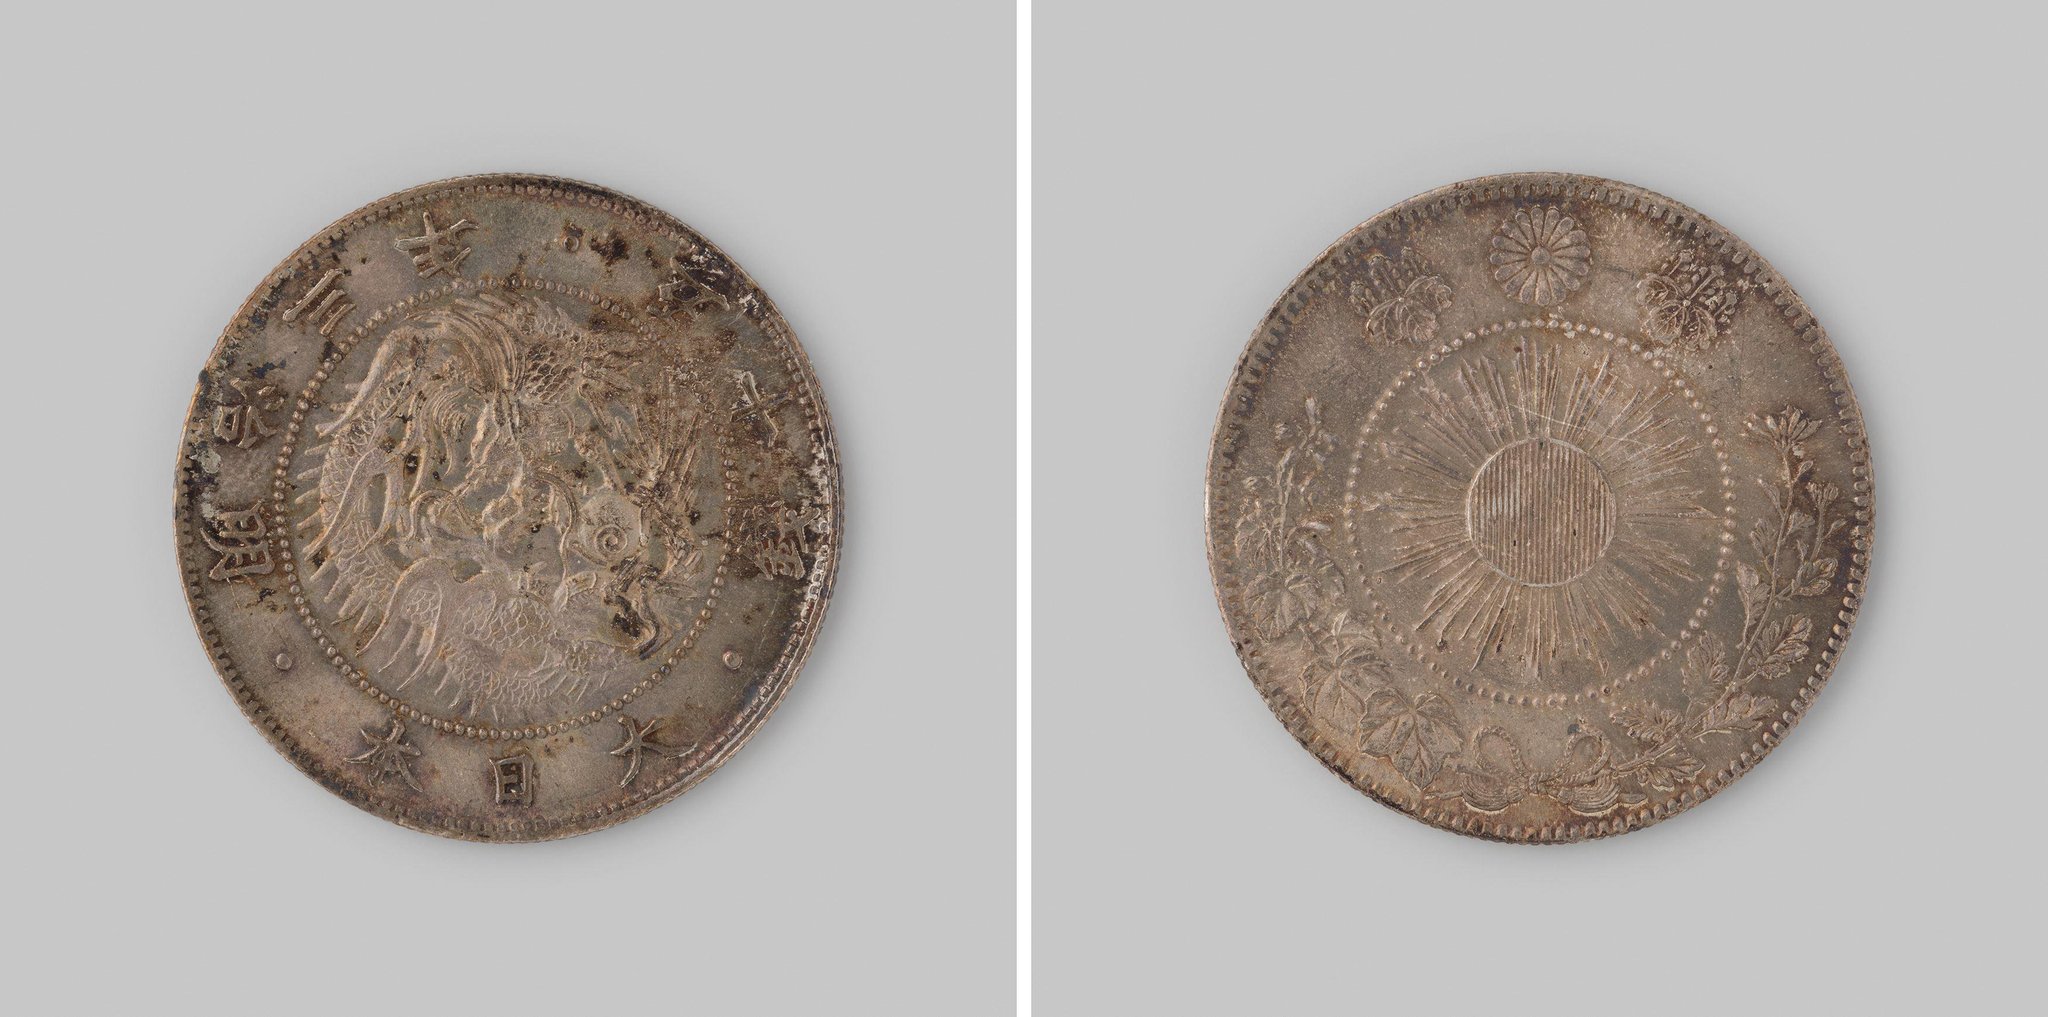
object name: coin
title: Keizerrijk Japan, Meiji tijdperk, 50 sen, regeringsjaar 3 [=1870]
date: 1870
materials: silver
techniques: striking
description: Zilveren munt. Voorzijde: binnen cirkel gestileerde draak met in omschrift onderaan waarde-aanduiding. Keerzijde: tussen twee samengebonden takken, waarboven symbolen, binnen cirkel zon met stralen. Kartelrand.